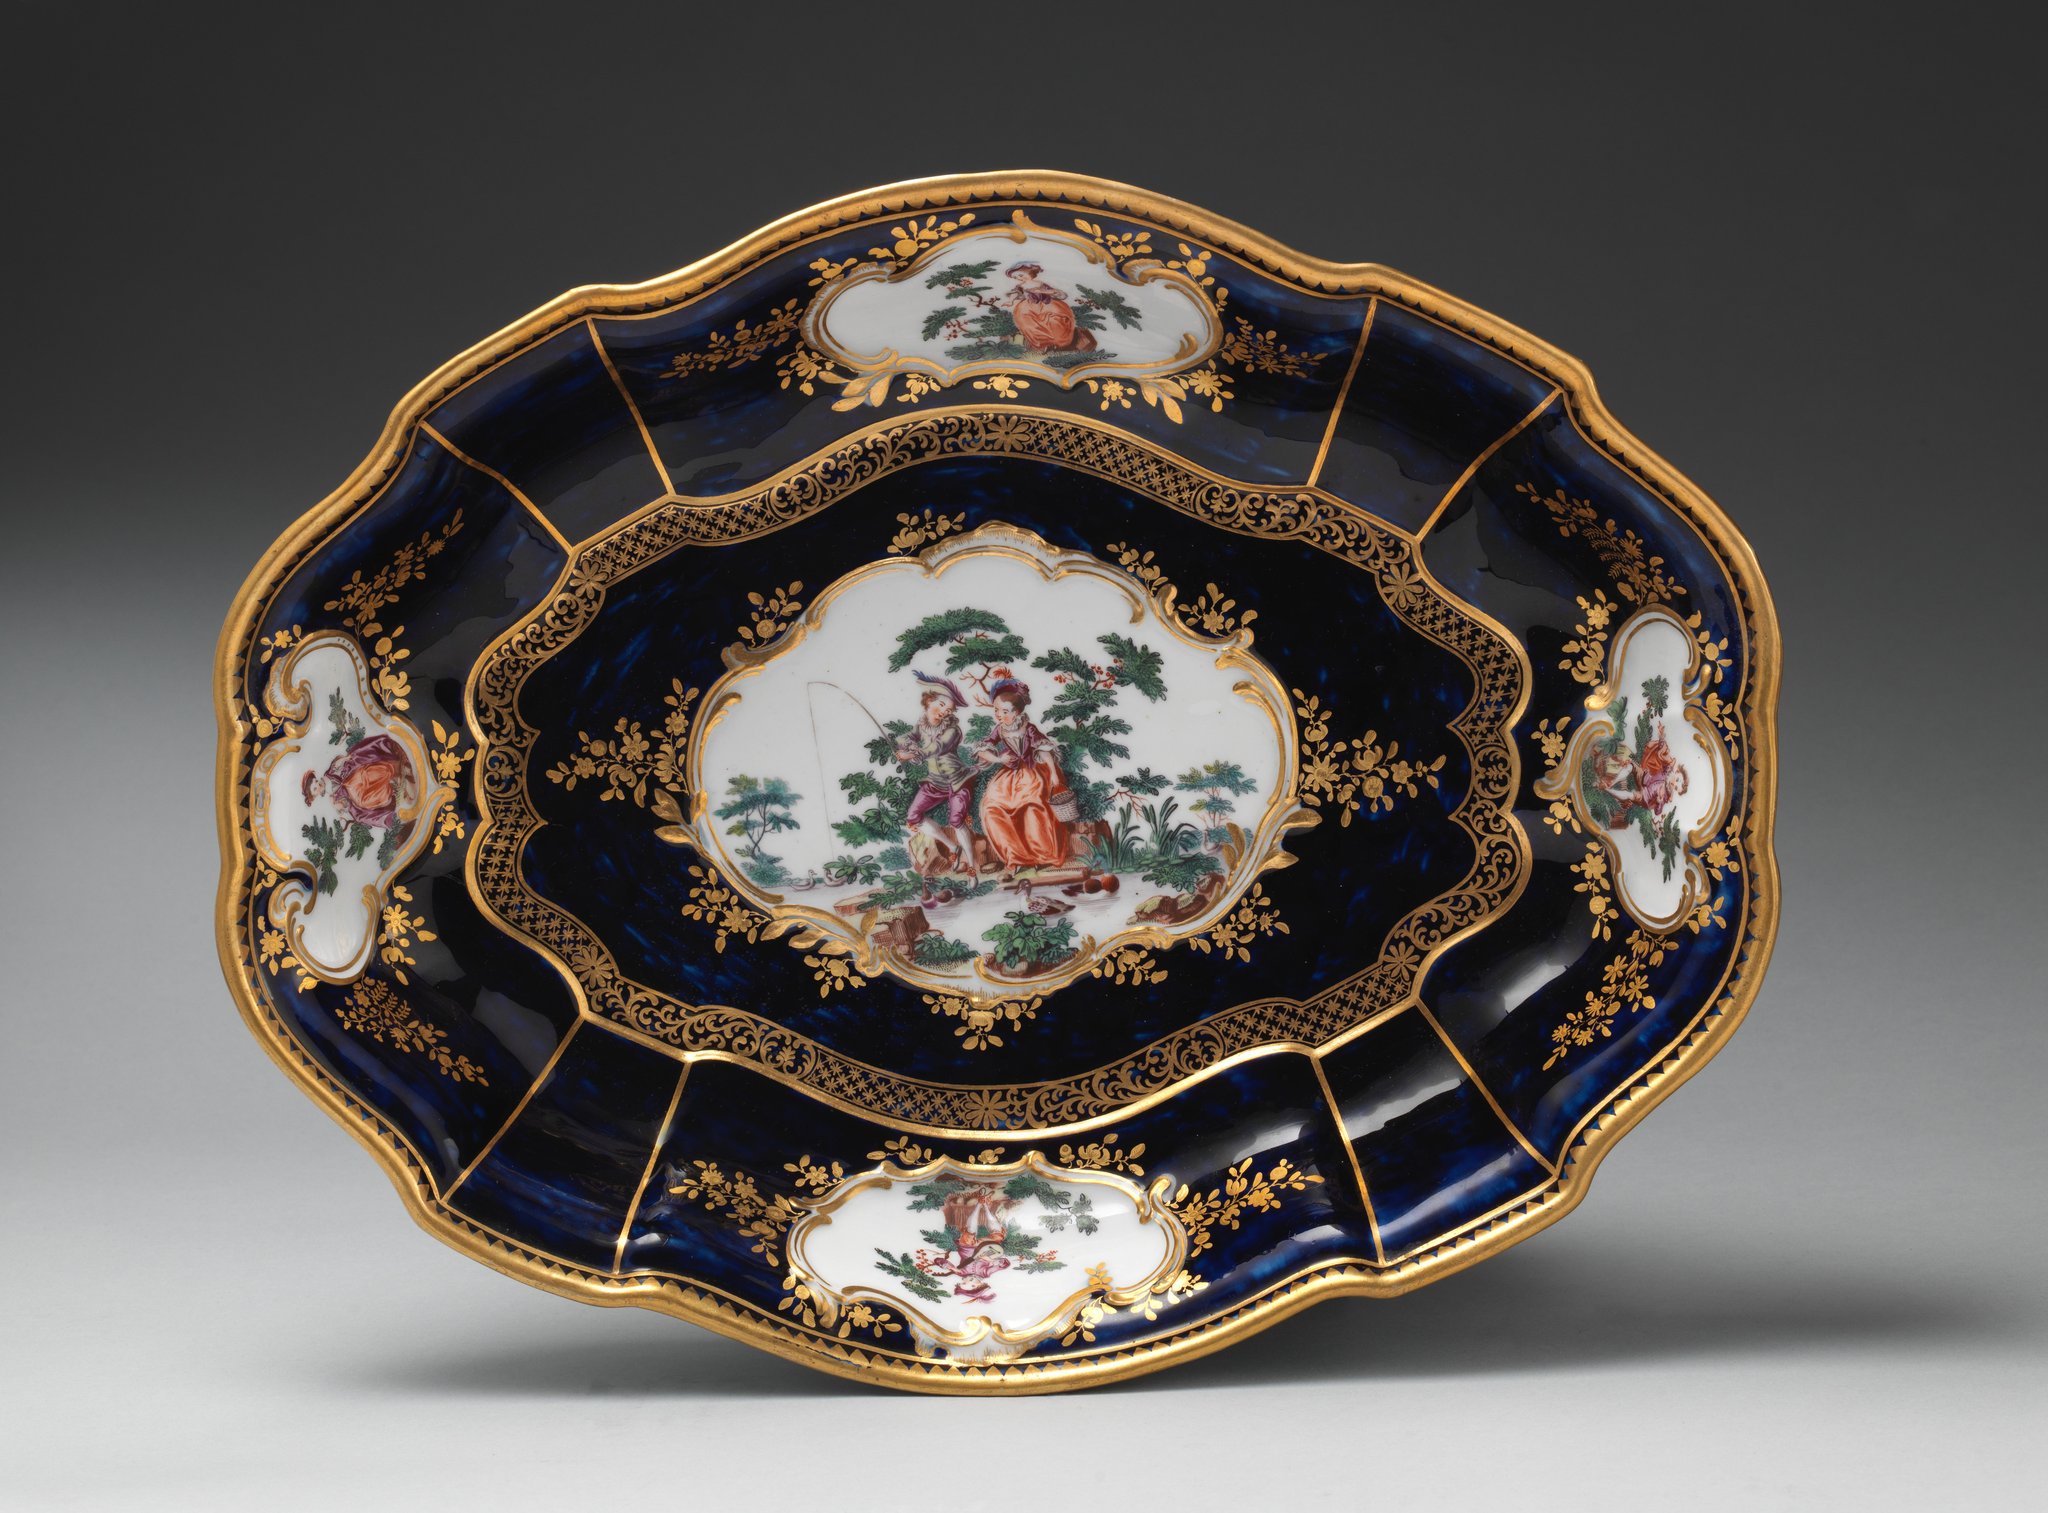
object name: basin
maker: chelsea porcelain manufactory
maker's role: factory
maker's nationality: british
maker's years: 1744-1784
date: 1761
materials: soft paste porcelain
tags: men,women,fishing